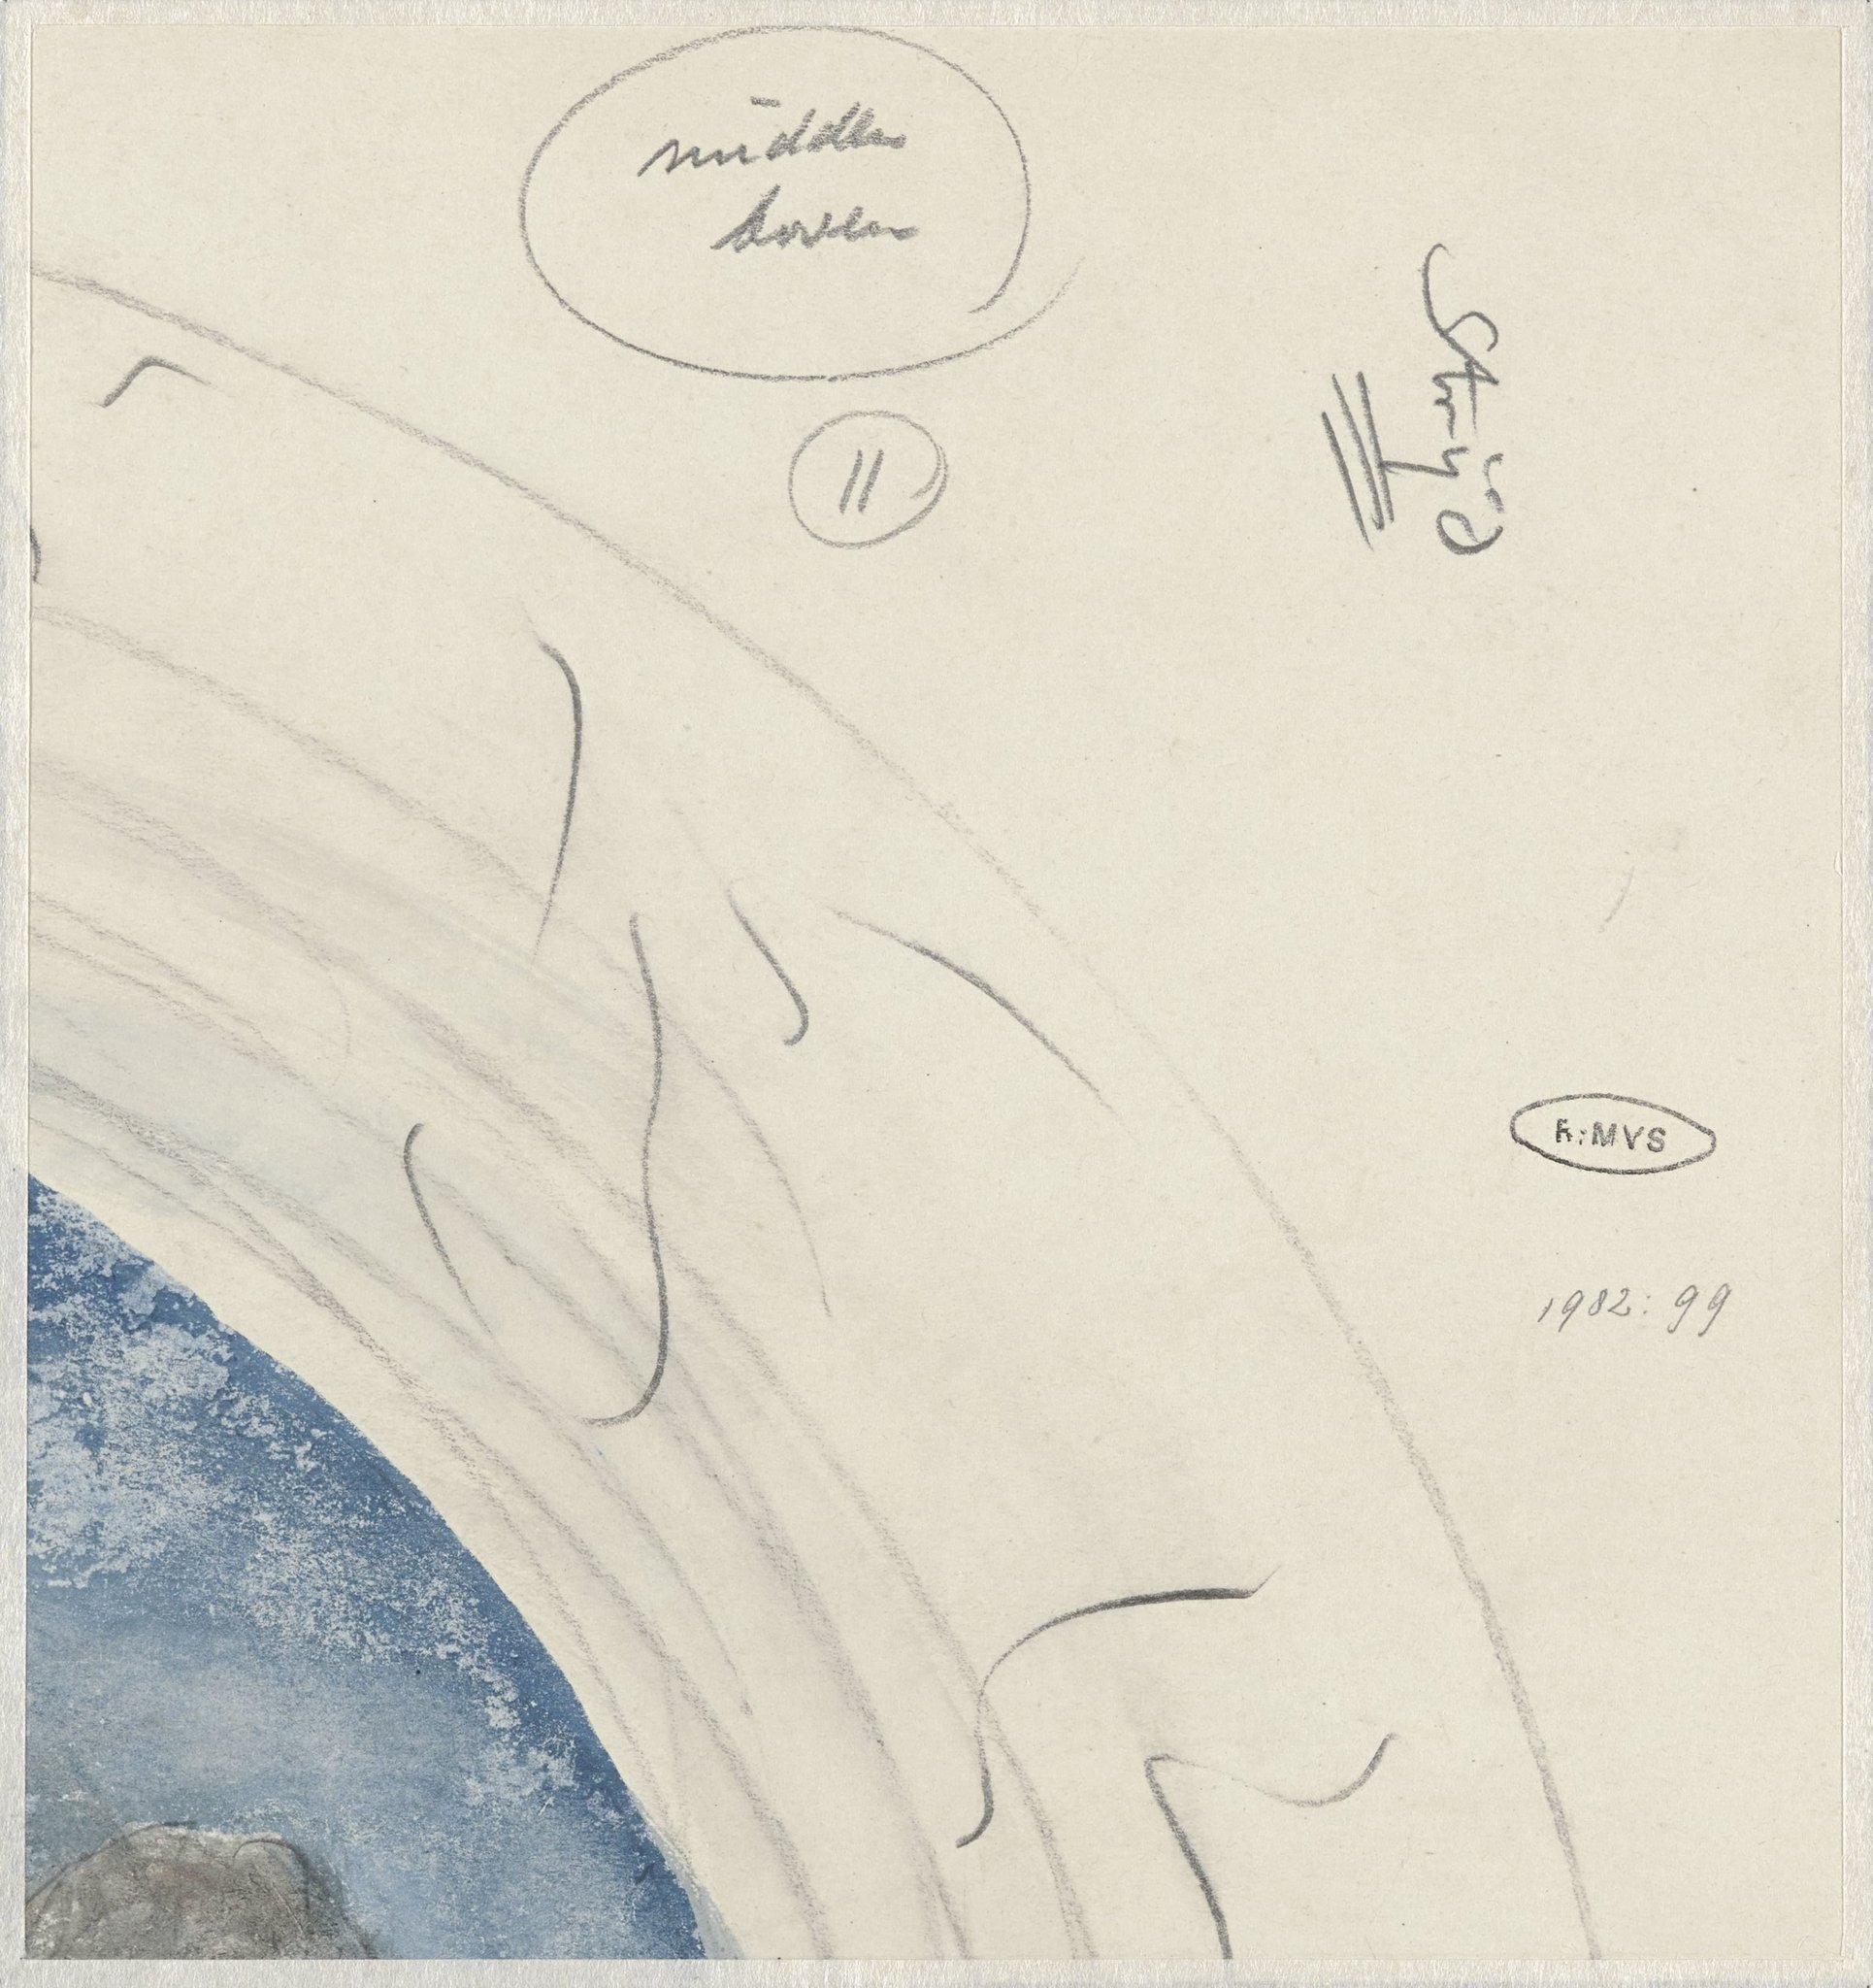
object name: design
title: Fragment van een ontwerp voor een schotel van aardewerk genaamd Strijd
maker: theo colenbrander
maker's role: draughtsman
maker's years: 1841-1930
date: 1919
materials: paper, pencil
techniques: brush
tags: dish, plate, saucer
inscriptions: date